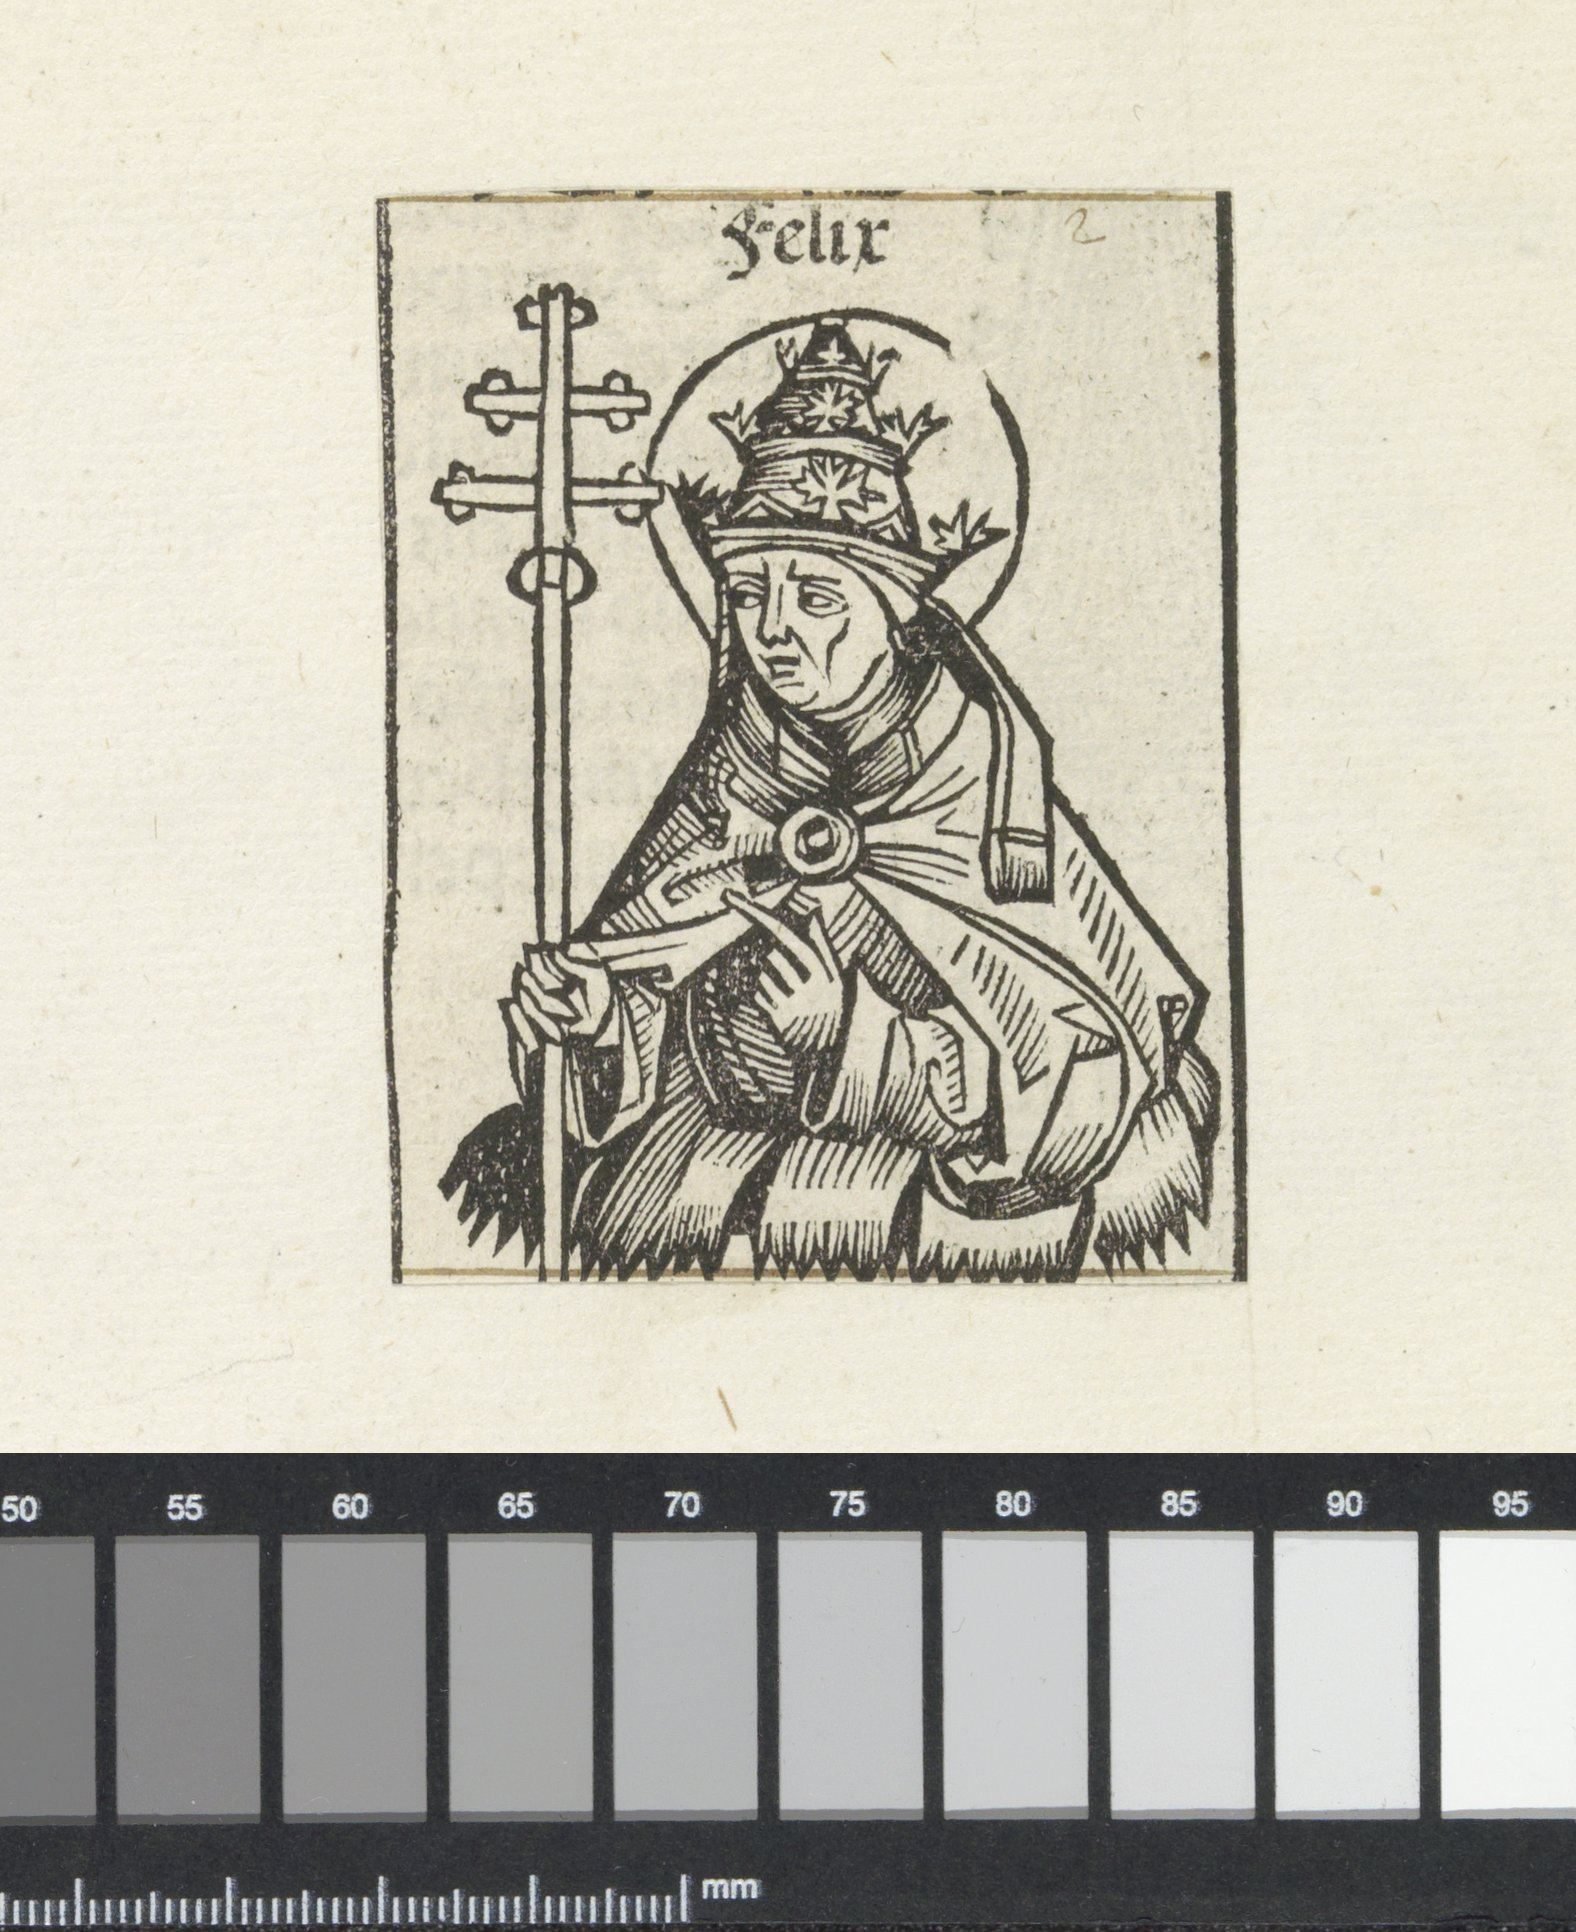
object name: print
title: Felix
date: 1493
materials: paper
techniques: letterpress printing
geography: nuremberg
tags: rome, pope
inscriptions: inscription: ‘2’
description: Een bloemkelk met een paus. Hij draagt een tiara en heeft een staf met een dubbel kruis in zijn handen. De nimbus om zijn hoofd vertelt dat deze paus heilig is verklaard. De voorstelling is onderdeel van de opeenvolging pausen in de Liber Chronicarum. De tekst identificeert de man als paus Felix III. De prent maakt deel uit van een album.